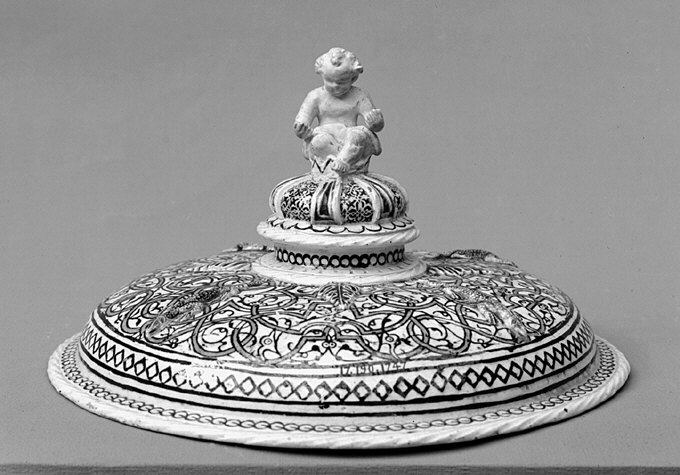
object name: tazza with cover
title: Tazza cover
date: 1534-1566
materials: earthenware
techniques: inlay, glazing, molding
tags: children